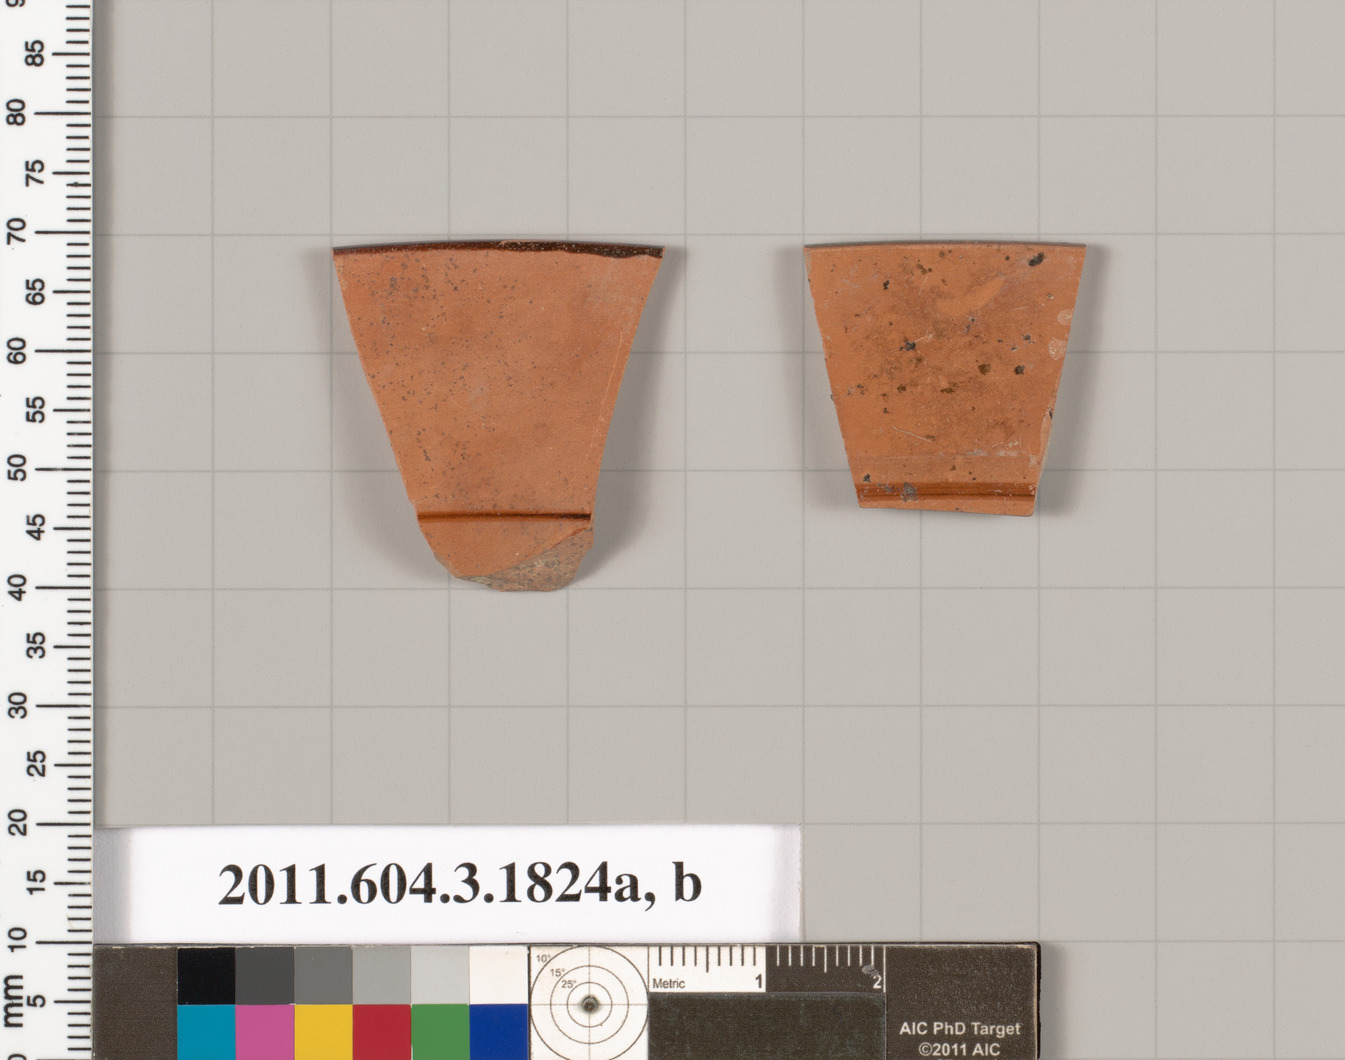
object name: kylix fragment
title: Terracotta rim fragments of kylikes: Lip cup (drinking cup)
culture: greek, attic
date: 560-525 BCE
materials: terracotta